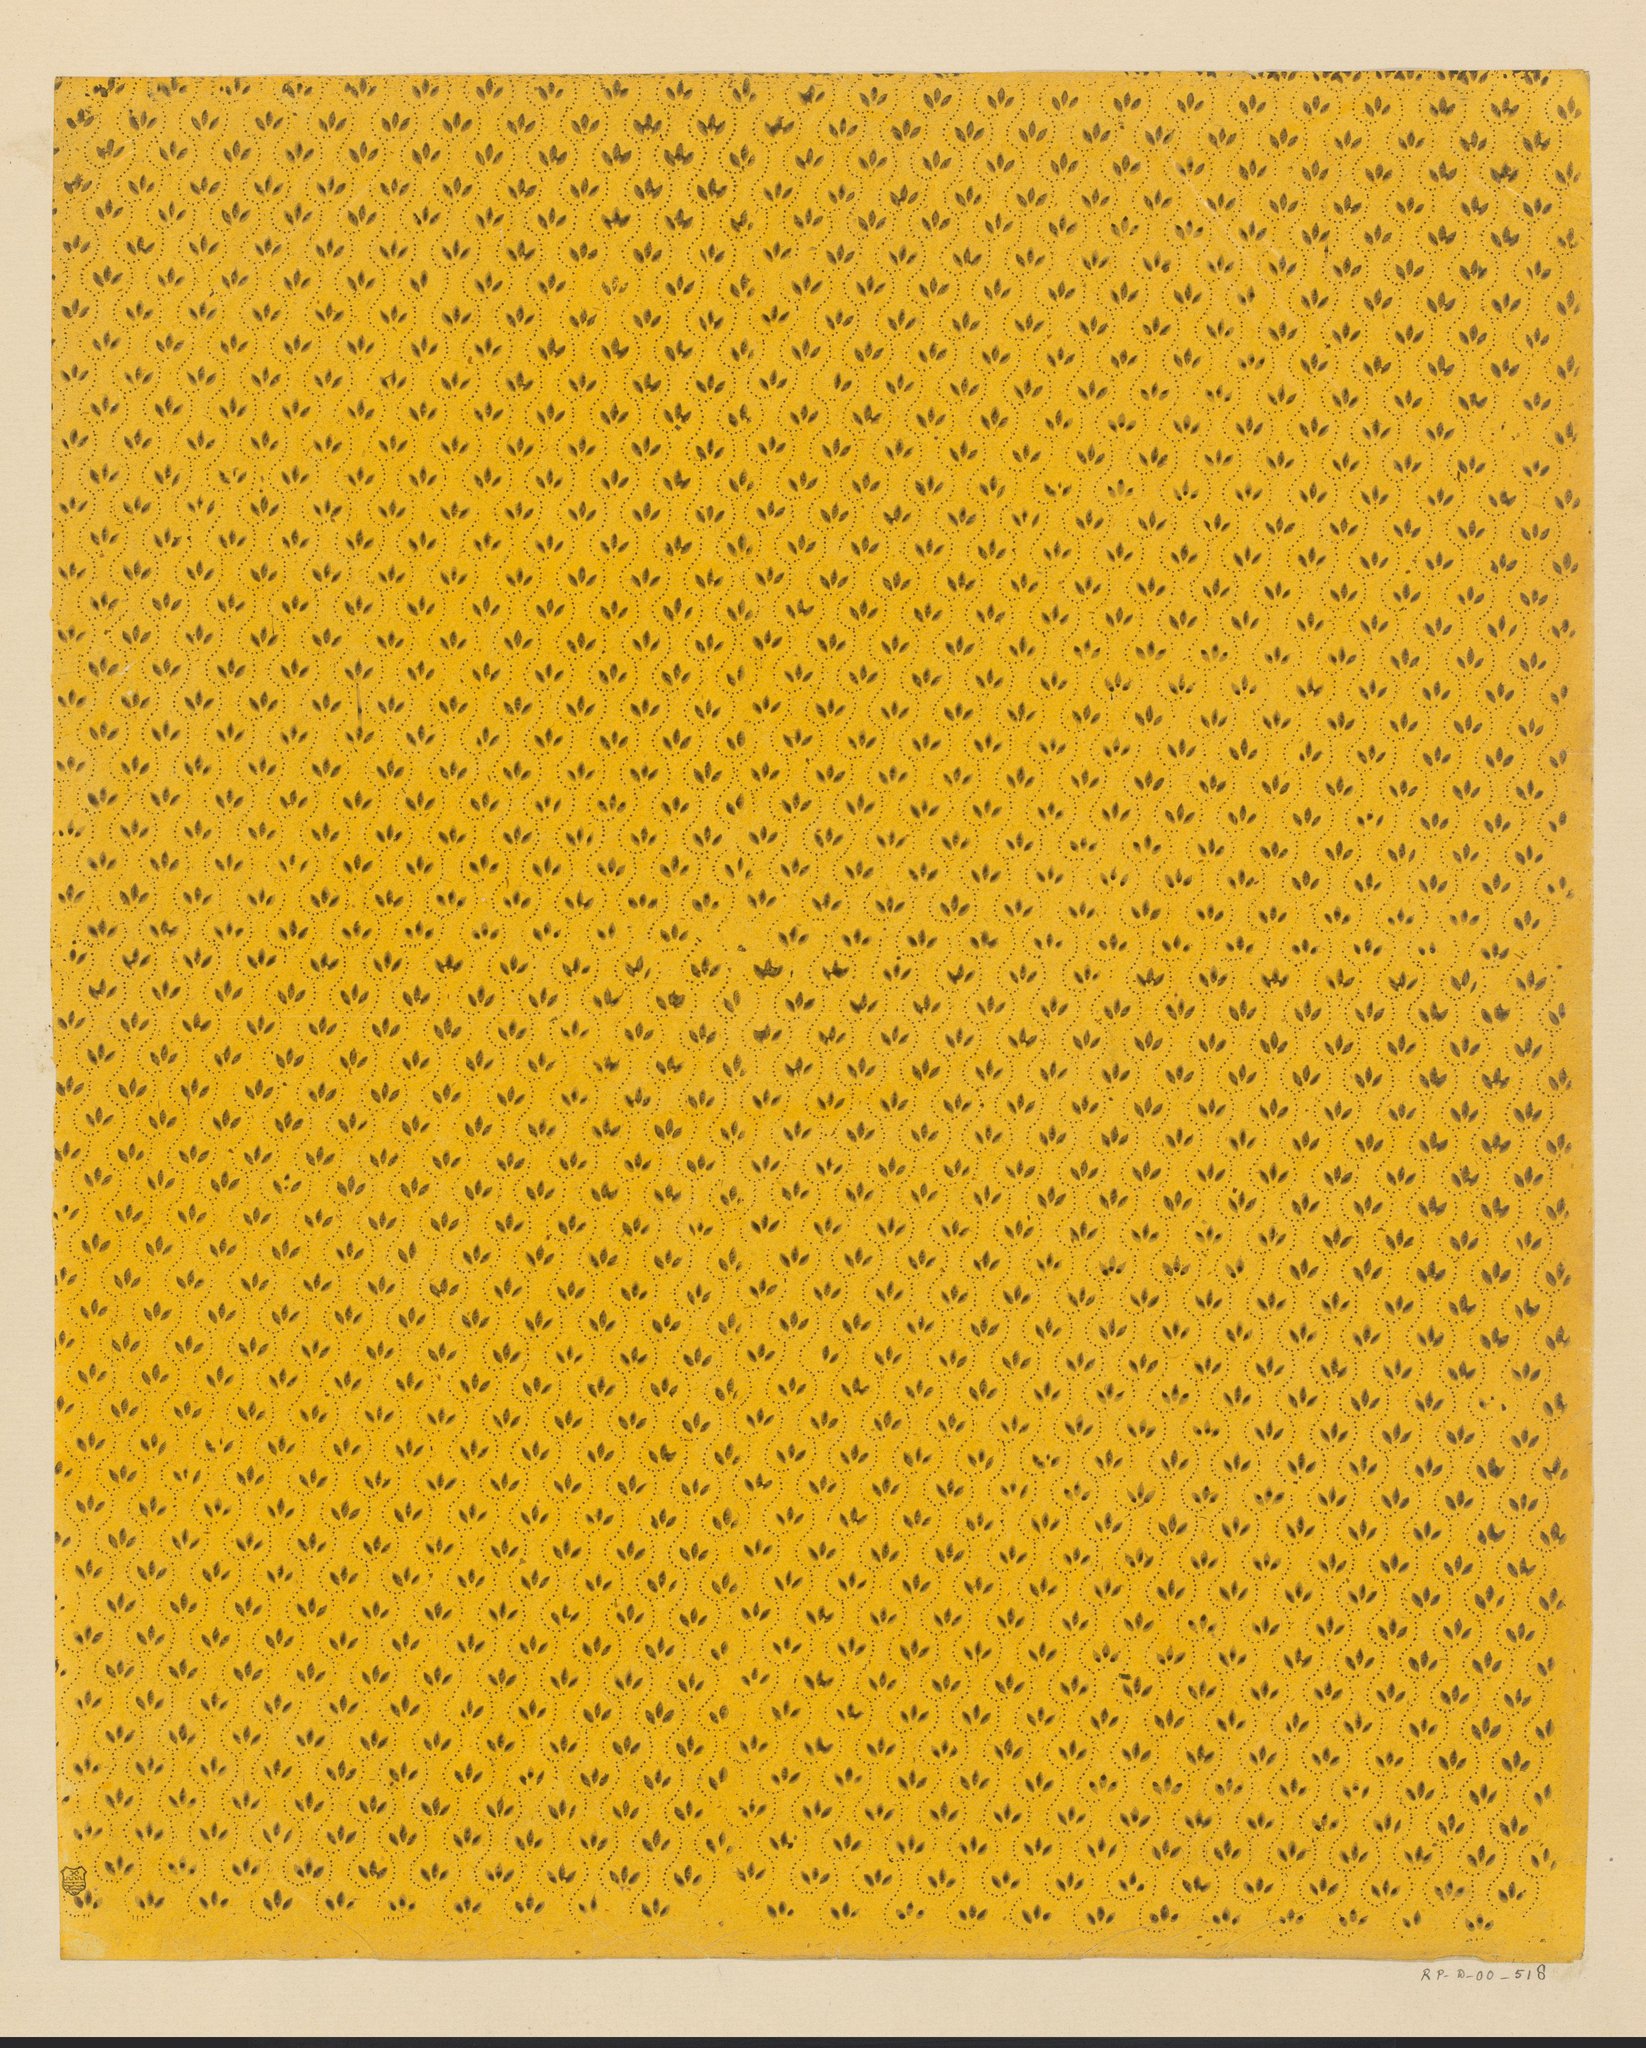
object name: printed paper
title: Blad met banenpatroon van drie blaadjes tussen slingerende stippellijnen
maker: Anonymous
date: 1800-1900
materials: paint, paper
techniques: printing block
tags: ornament derived from plant forms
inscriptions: collector's mark: Lugt 2760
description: Blad met verticaal banenpatroon van motief van drie blaadjes tussen golvende stippellijnen.